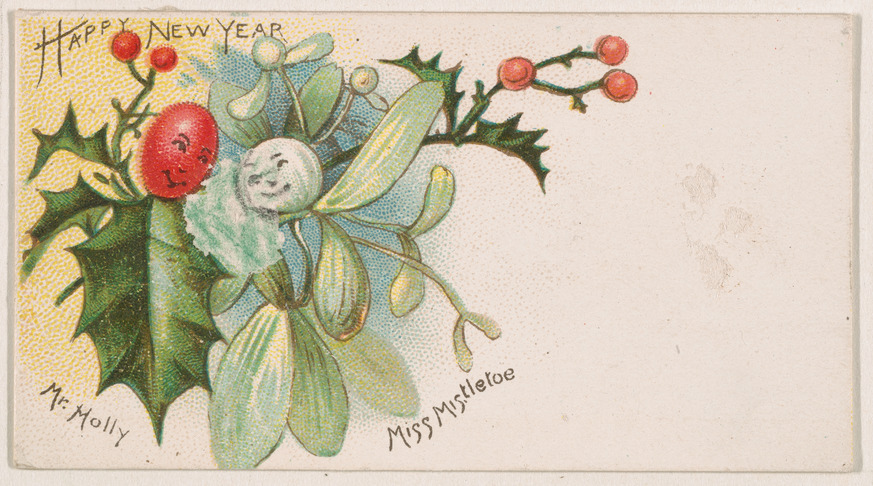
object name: print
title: Happy New Year, Mr. Holly and Miss Mistletoe, from the New Years 1890 series (N227) issued by Kinney Bros.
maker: kinney brothers tobacco company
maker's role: publisher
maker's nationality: american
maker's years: 1869-2011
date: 1889-1890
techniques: color lithograph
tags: fruit,leaves